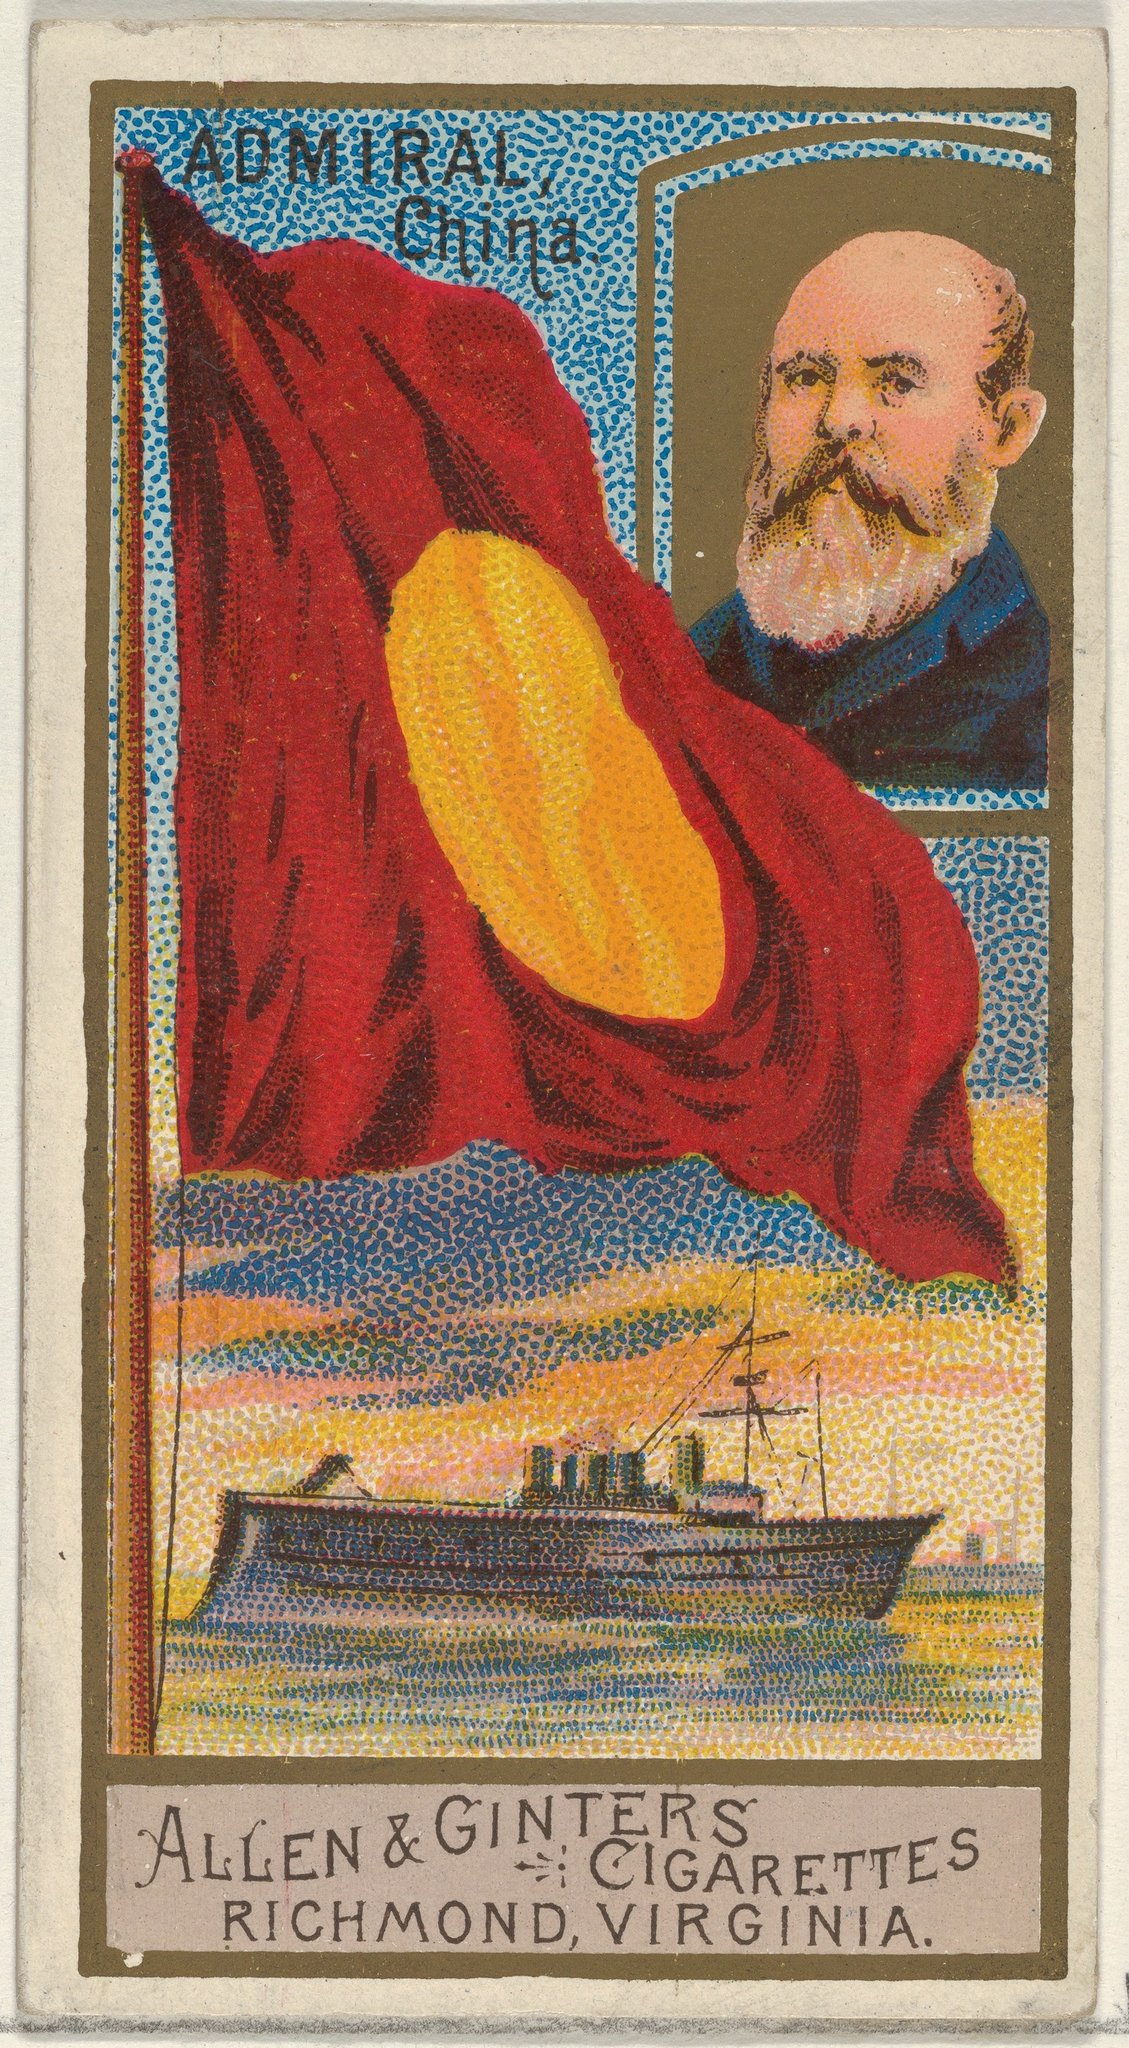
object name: print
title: Admiral, China, from the Naval Flags series (N17) for Allen & Ginter Cigarettes Brands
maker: allen & ginter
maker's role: publisher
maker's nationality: american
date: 1888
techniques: color lithograph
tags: men,flags,admirals